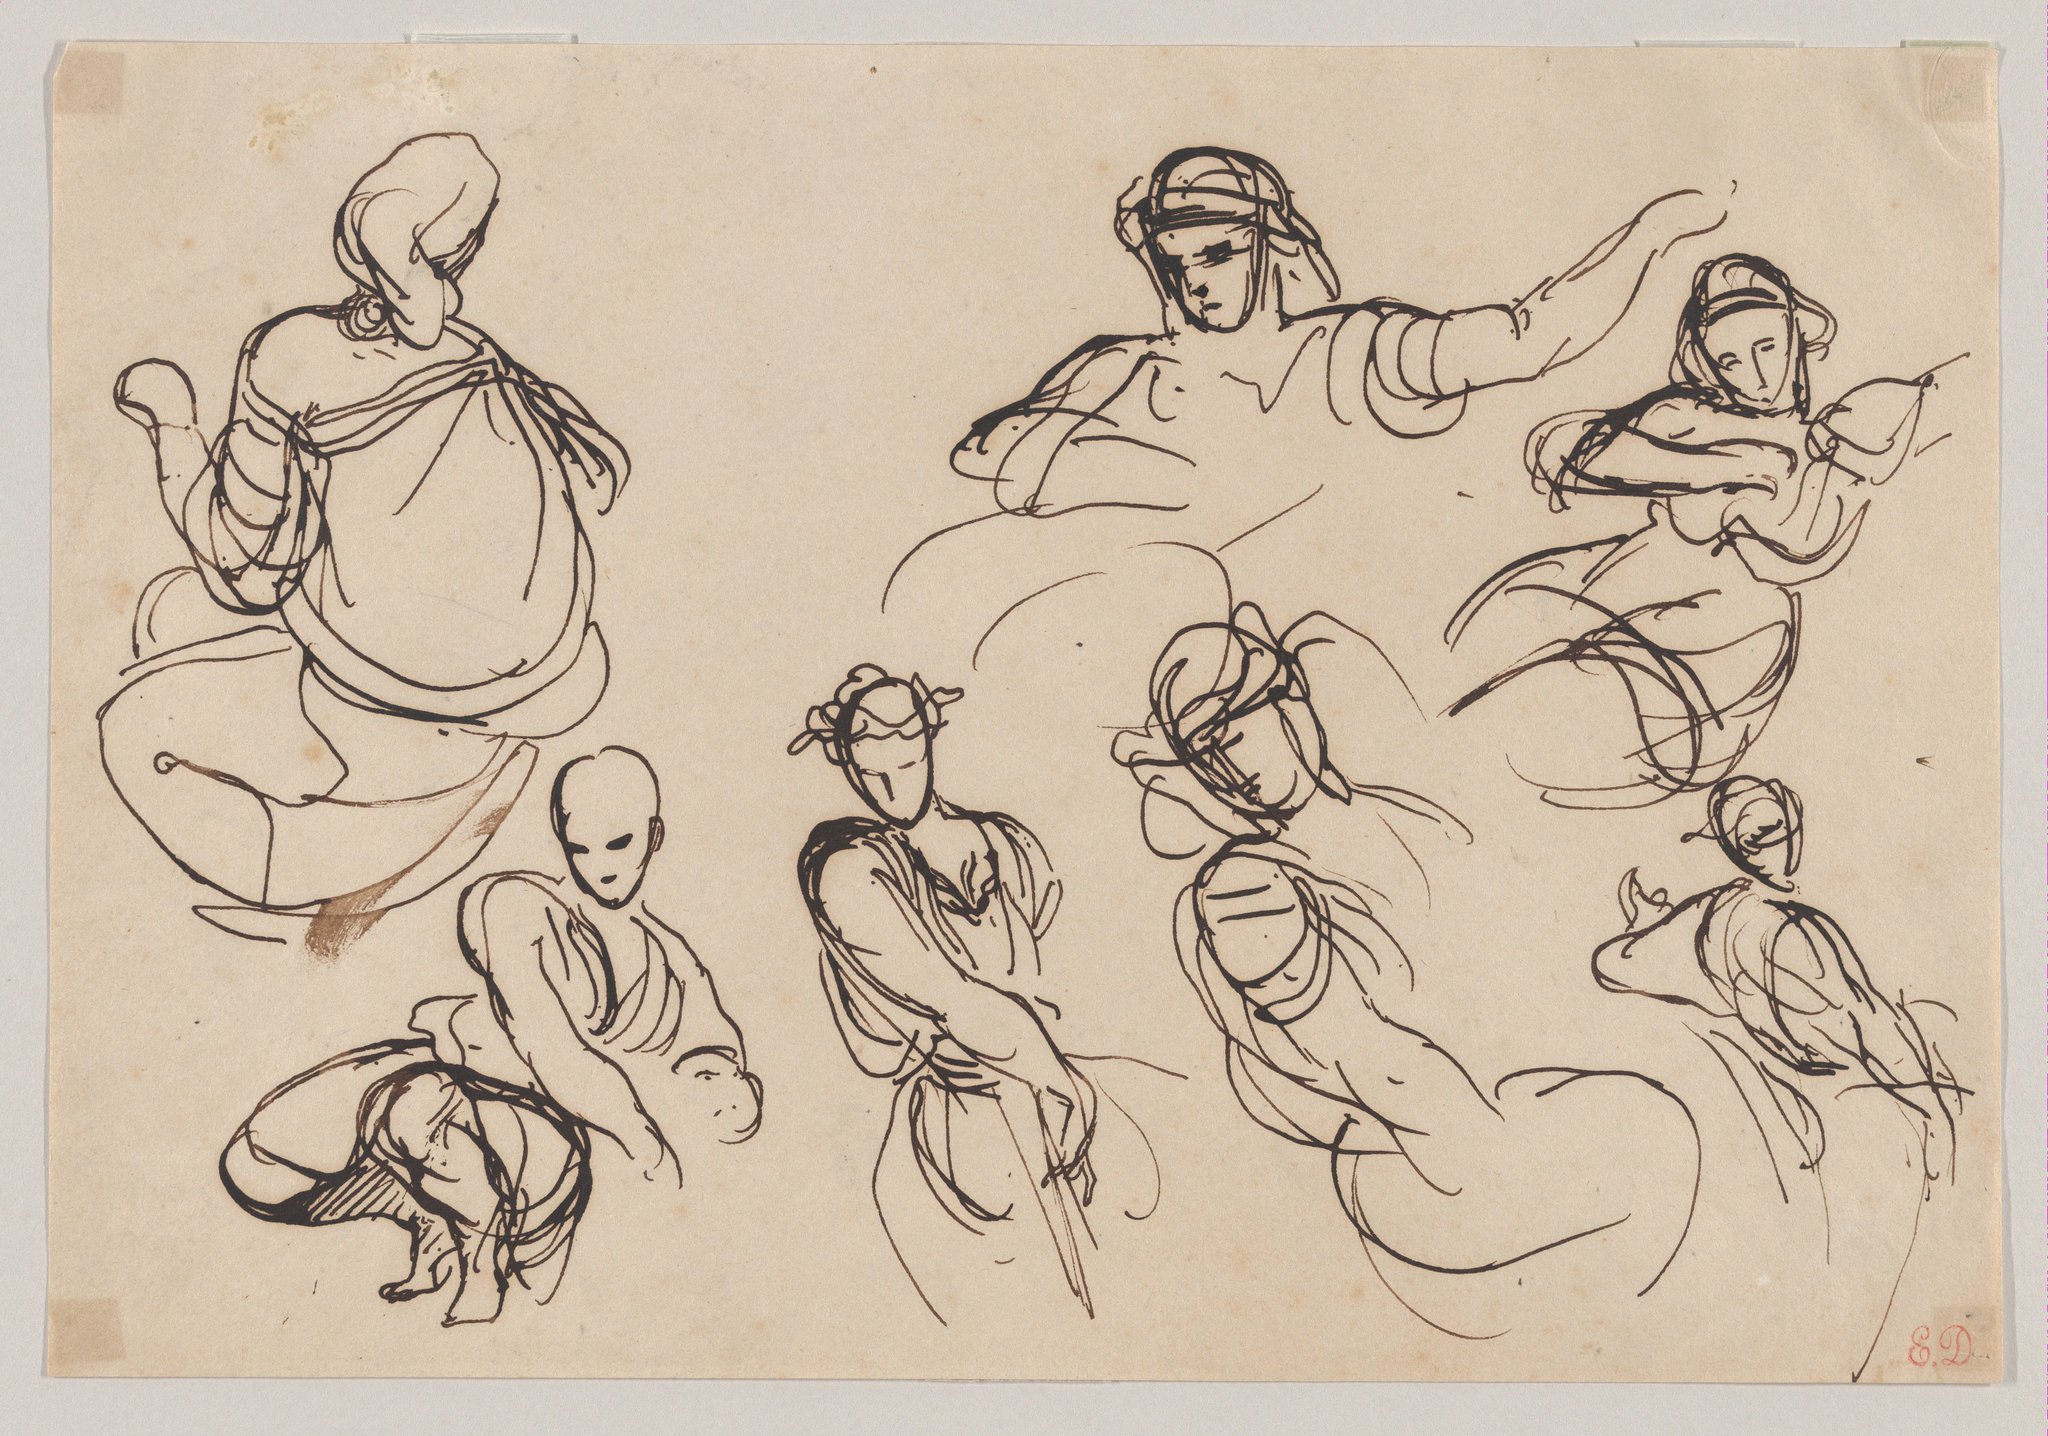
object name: drawing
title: Figures Studies for the Salon du Roi, Palais Bourbon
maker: eugène delacroix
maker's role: artist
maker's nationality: french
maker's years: 1798-1863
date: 1833-1835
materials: ink, iron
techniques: pen